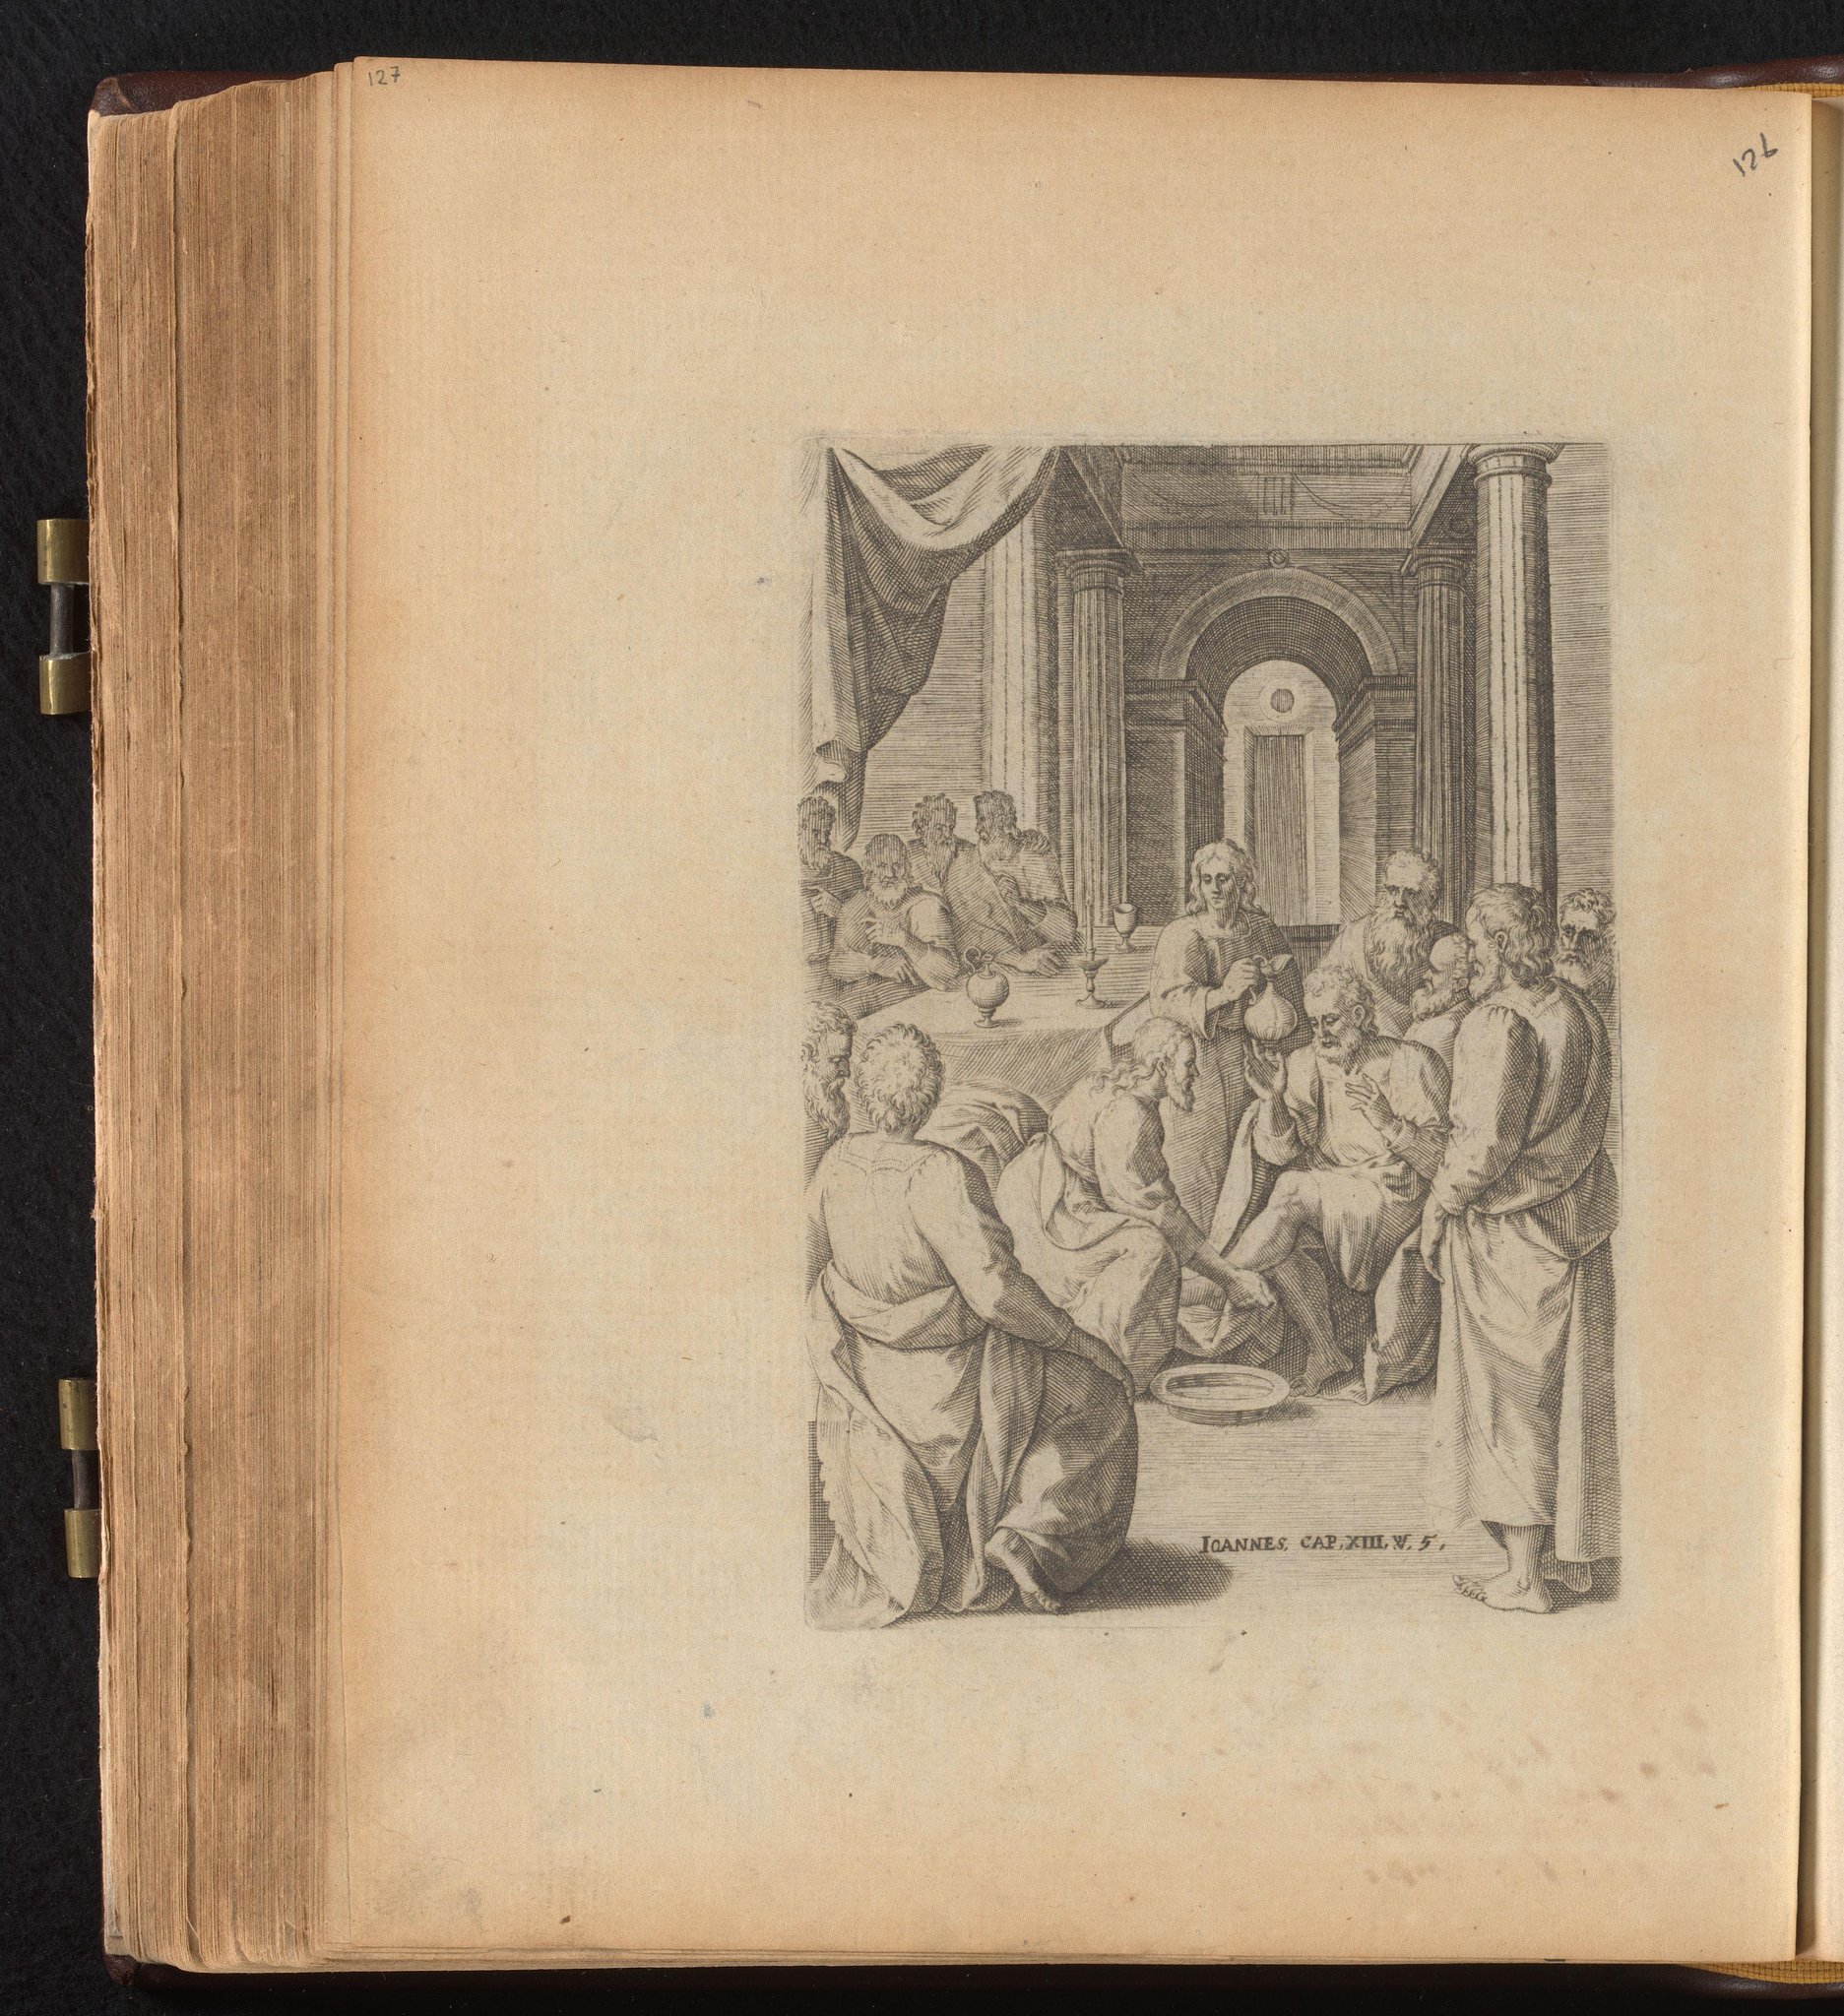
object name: album leaf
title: Voetwassing van Petrus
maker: Anonymous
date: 1583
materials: paper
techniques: engraving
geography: southern netherlands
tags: christ washes peter's feet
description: Eerdere staat van prent gebruikt als boekillustratie in: Biblia Sacra. Antwerpen: Christoffel Plantijn, 1583.